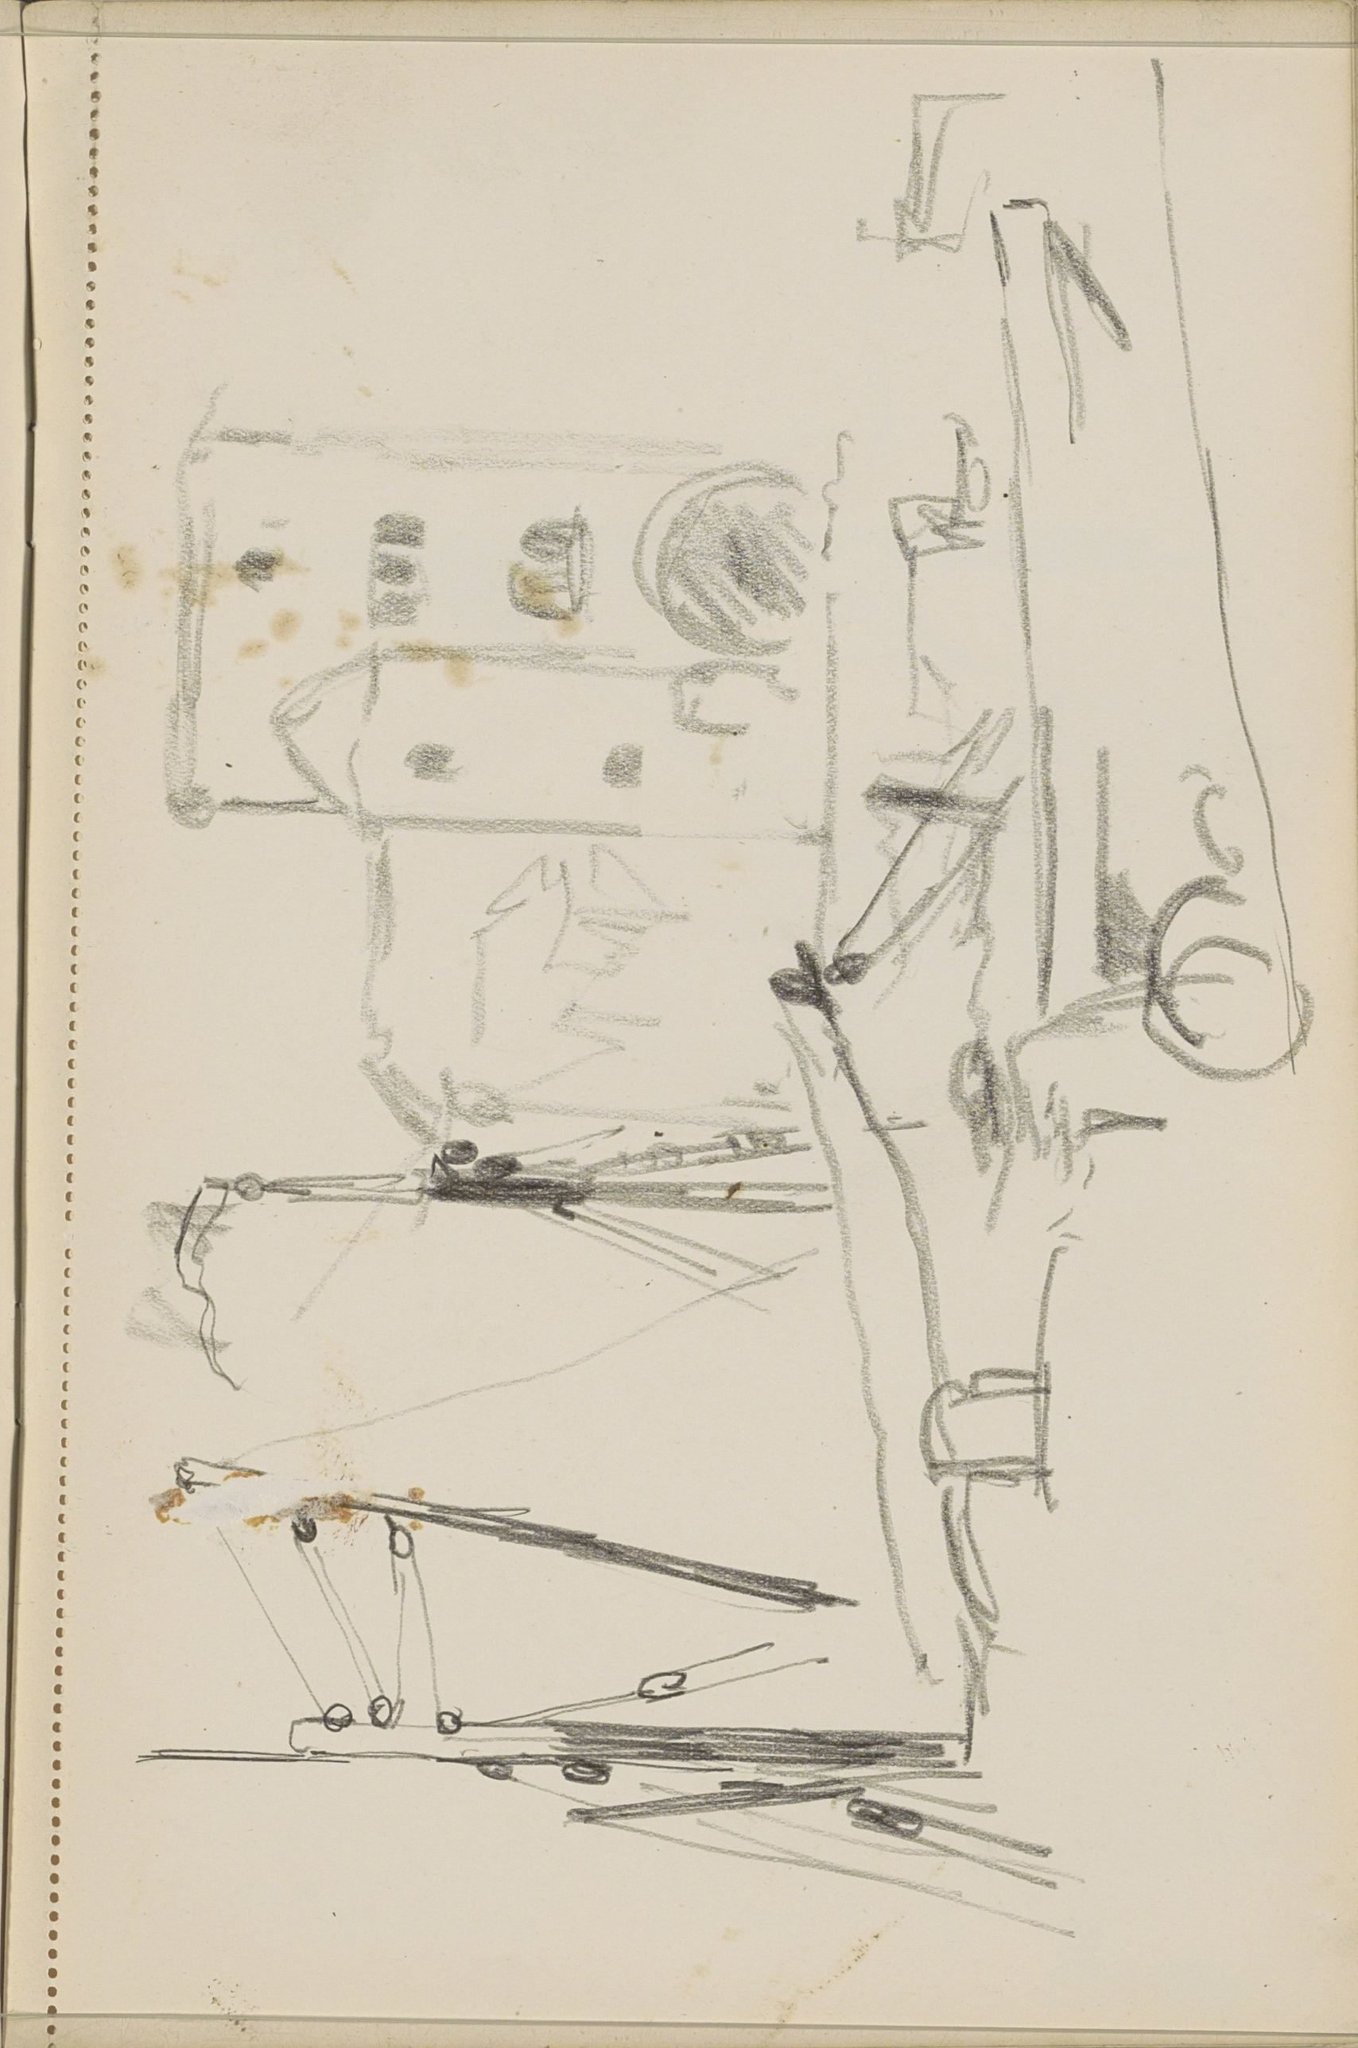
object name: sketchbook leaf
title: Aangemeerde zeilboot aan een kade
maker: cornelis vreedenburgh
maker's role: draughtsman, print maker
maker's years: 1880-1946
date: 1890-1946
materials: chalk, paper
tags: sailing-ship, sailing-boat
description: Op de achtergrond huizen. Blad 31 recto uit een schetsboek met 59 bladen.